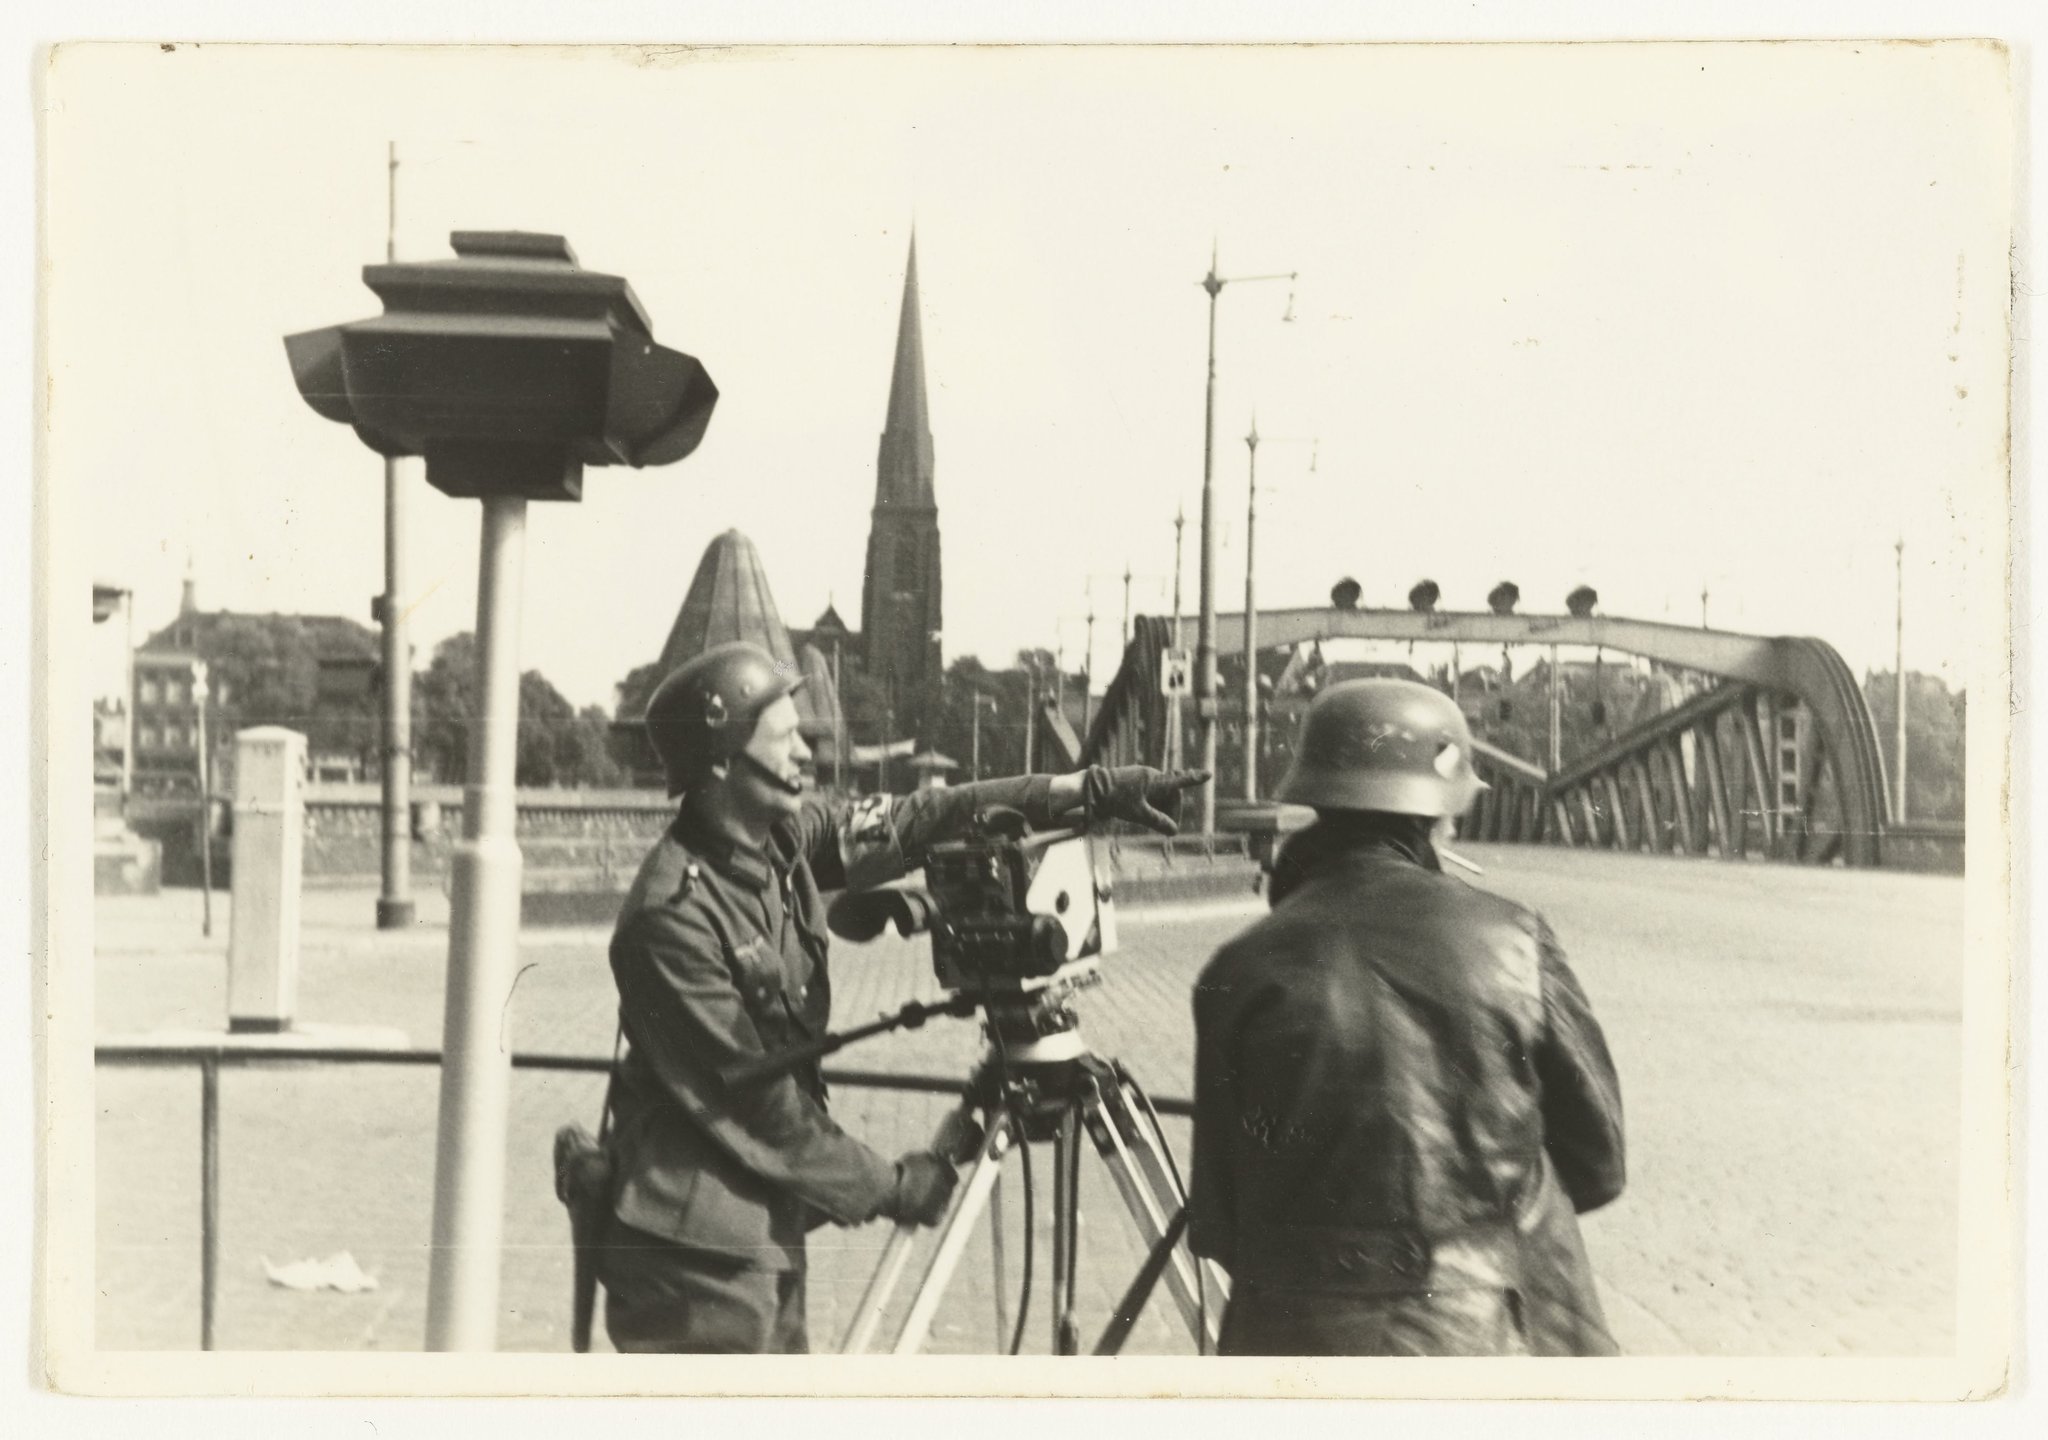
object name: photograph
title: Leden van een Duitse Propaganda Kompagnie.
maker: Anonymous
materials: photographic support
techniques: gelatin silver print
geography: rotterdam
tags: filming, cinematographer at work, rotterdam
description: Twee Duitse leden van een Propaganda Kompagnie maken filmopnamen bij een brug in een stad. De cameraman wijst naar rechts. Beide dragen een helm. Links van hen een alarm. Naast de brug een kerktoren.